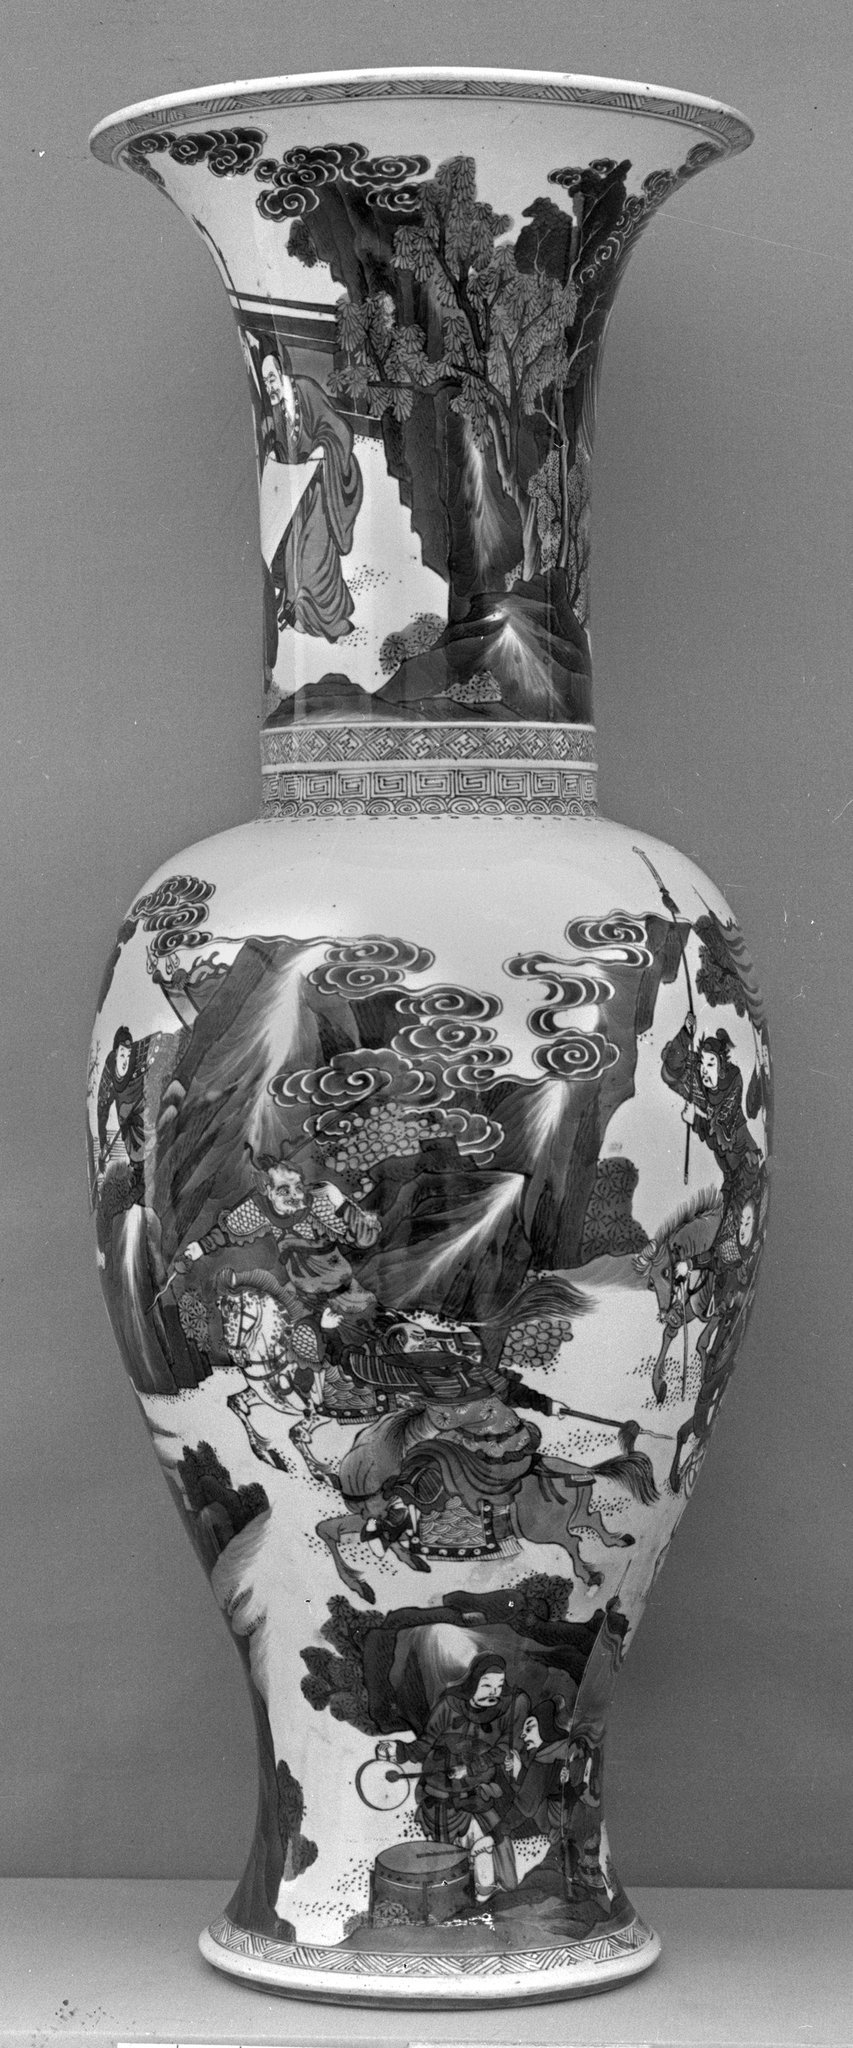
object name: vase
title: Vase with figural scene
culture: chinese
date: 1667-1733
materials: cobalt, porcelain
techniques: painting, underglaze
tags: men,horses,warriors